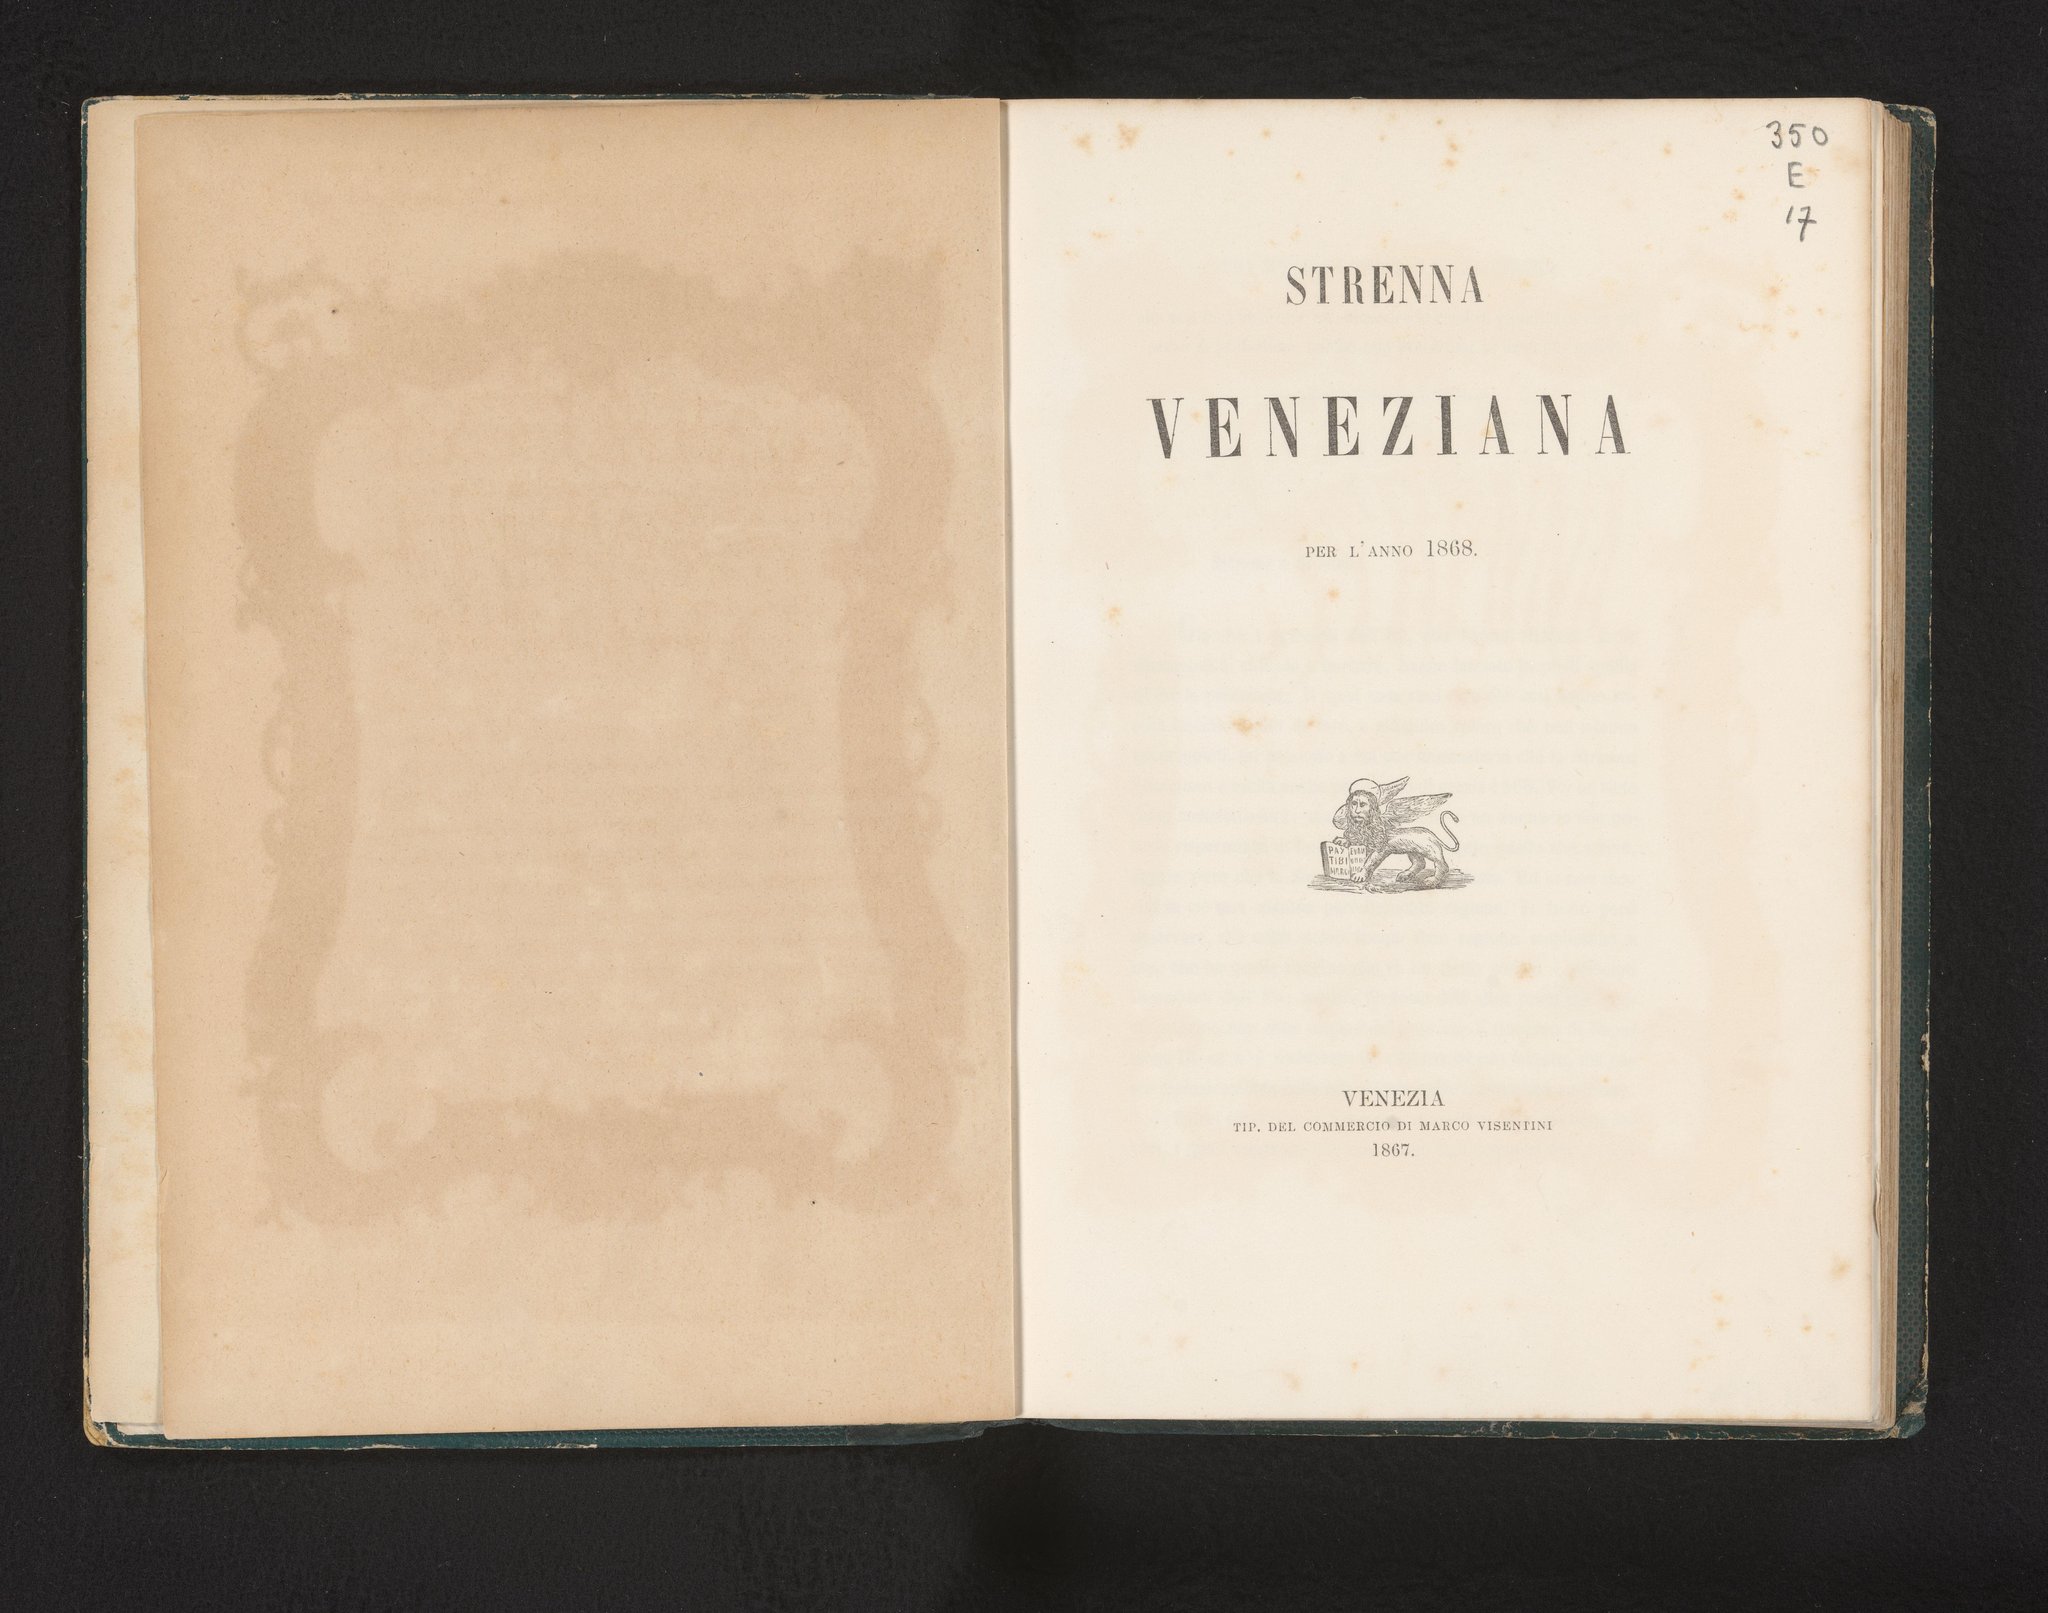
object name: book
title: Strenna Veneziana per l'anno 1868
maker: marco visentini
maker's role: publisher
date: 1867-1868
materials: cardboard, linen, paper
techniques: albumen print, letterpress printing, lithograph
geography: venice